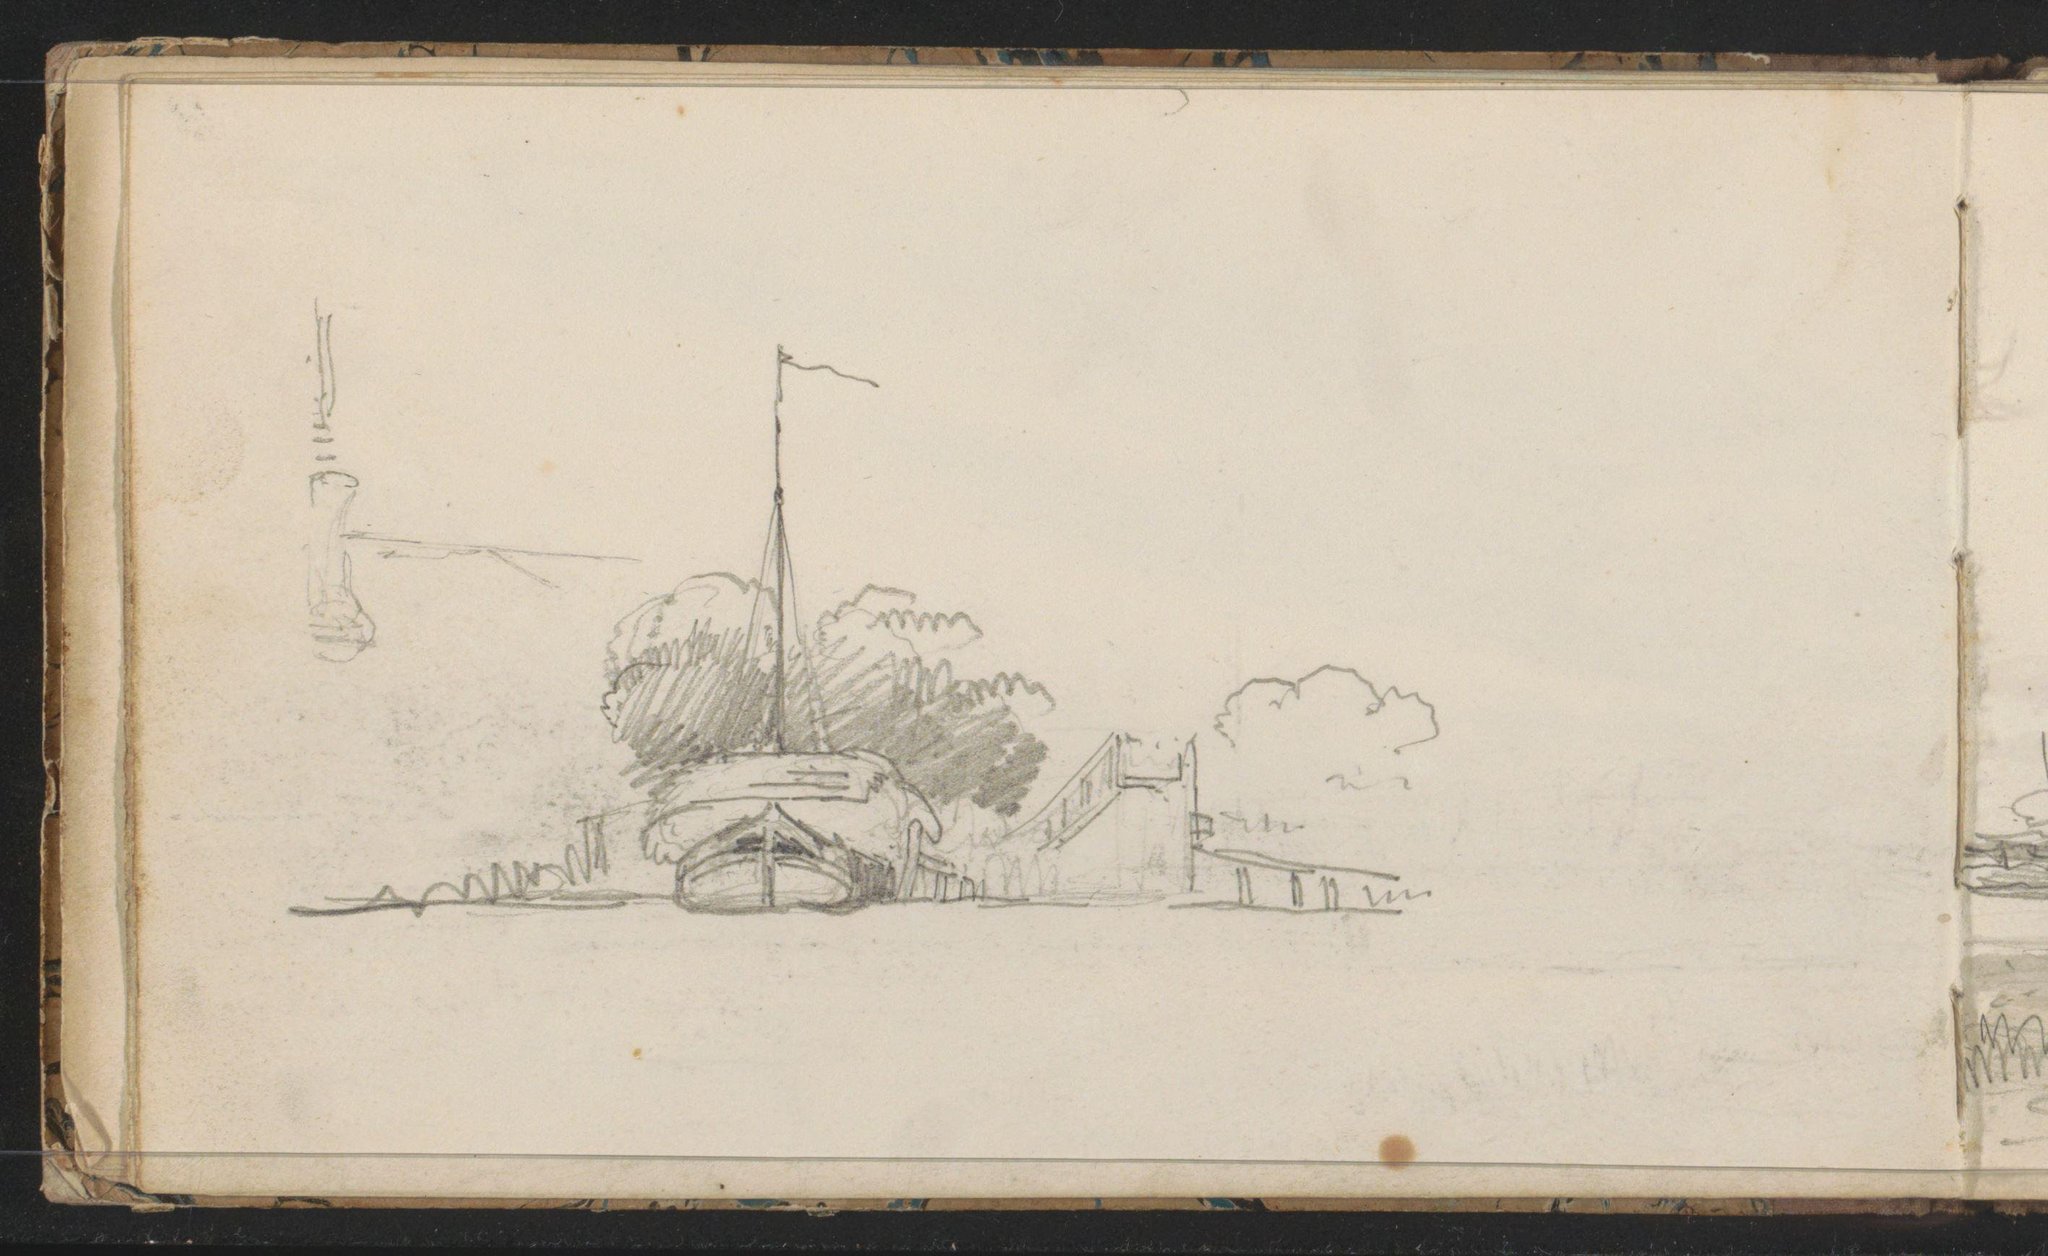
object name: sketchbook leaf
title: Zeilboot bij een steiger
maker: arnoldus johannes eymer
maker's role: draughtsman, print maker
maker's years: 1803-1863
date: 1803-1818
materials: paper, pencil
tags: rowing-boat, canoe, etc., pier, quay, wharf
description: Bladzijde 20 uit een schetsboek met 74 bladzijden.